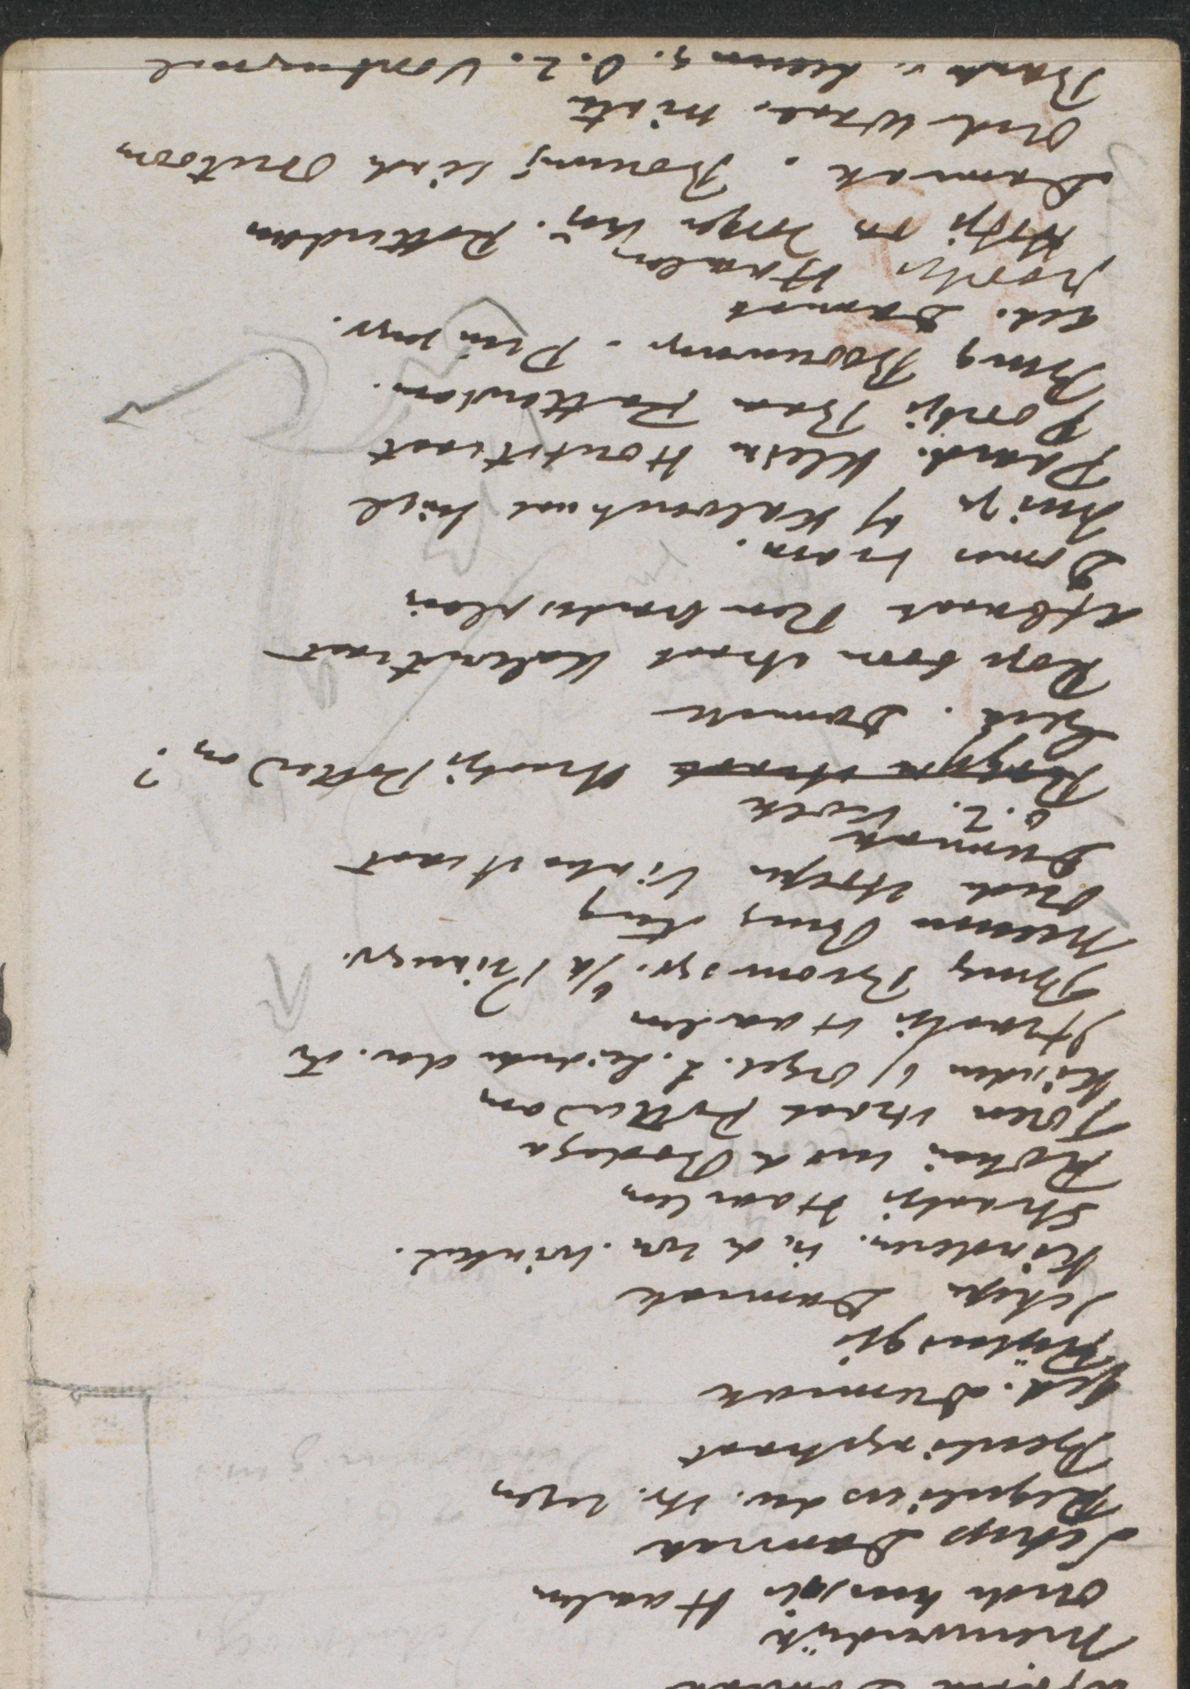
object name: endleaf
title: Annotaties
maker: george hendrik breitner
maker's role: draughtsman, painter, print maker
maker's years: 1857-1923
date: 1902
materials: ink, paper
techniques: writing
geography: amsterdam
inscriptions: annotation: ‘Huizen Singel/ Beursstraat Rokin/ Kalverstraat/ afbraak Damrak/ Nieuwendijk/ oude huisjes Haarlem/ Schip Damrak/ Reguliersdw. str. regen/ Beulingstraat/ ged. Damrak/ Rijtuigje/ Schepen Damrak/ Kinderen in de zon. winkel./ Straatje Haarlem/ Rokin uit de Bodega/ Toren straat Rotterdam/ Kinderen b/ orgel. L. Leidsche dw. str/ Straatje Haarlem/ Brug Brouwsgr. b/d Prinsengr./ Nieuwe Brug steeg/ oude stoepen Vinkenstraat/ Damrak/ O.Z. Kolk/ Bagijnestraat [doorgestreept] straatje Rotterdam?/ Gerz.[?] Damrak/ Rozeboomstraat Kalverstraat/ afbraak Rembrandtsplein/ Dames tram/ huizen b/ Kalverstraat Singel/ Paard. Kleine Houtstraat/ Poortje Baan Rotterdam./ Brug Brouwergr. Prinsengr./ ged. Damrak/ poortje Haarlem/ Hofje van Zorgen Vrij Rotterdam/ Damrak. Bouwrij einde Overtoom/ Oude water[?], winter/ Bank v. Leening. O.Z. Voorburgwal’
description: Pagina 94, achterste schutblad, uit een schetsboek met 46 bladen vervaardigd in de omgeving van Amsterdam, Rotterdam en Haarlem.